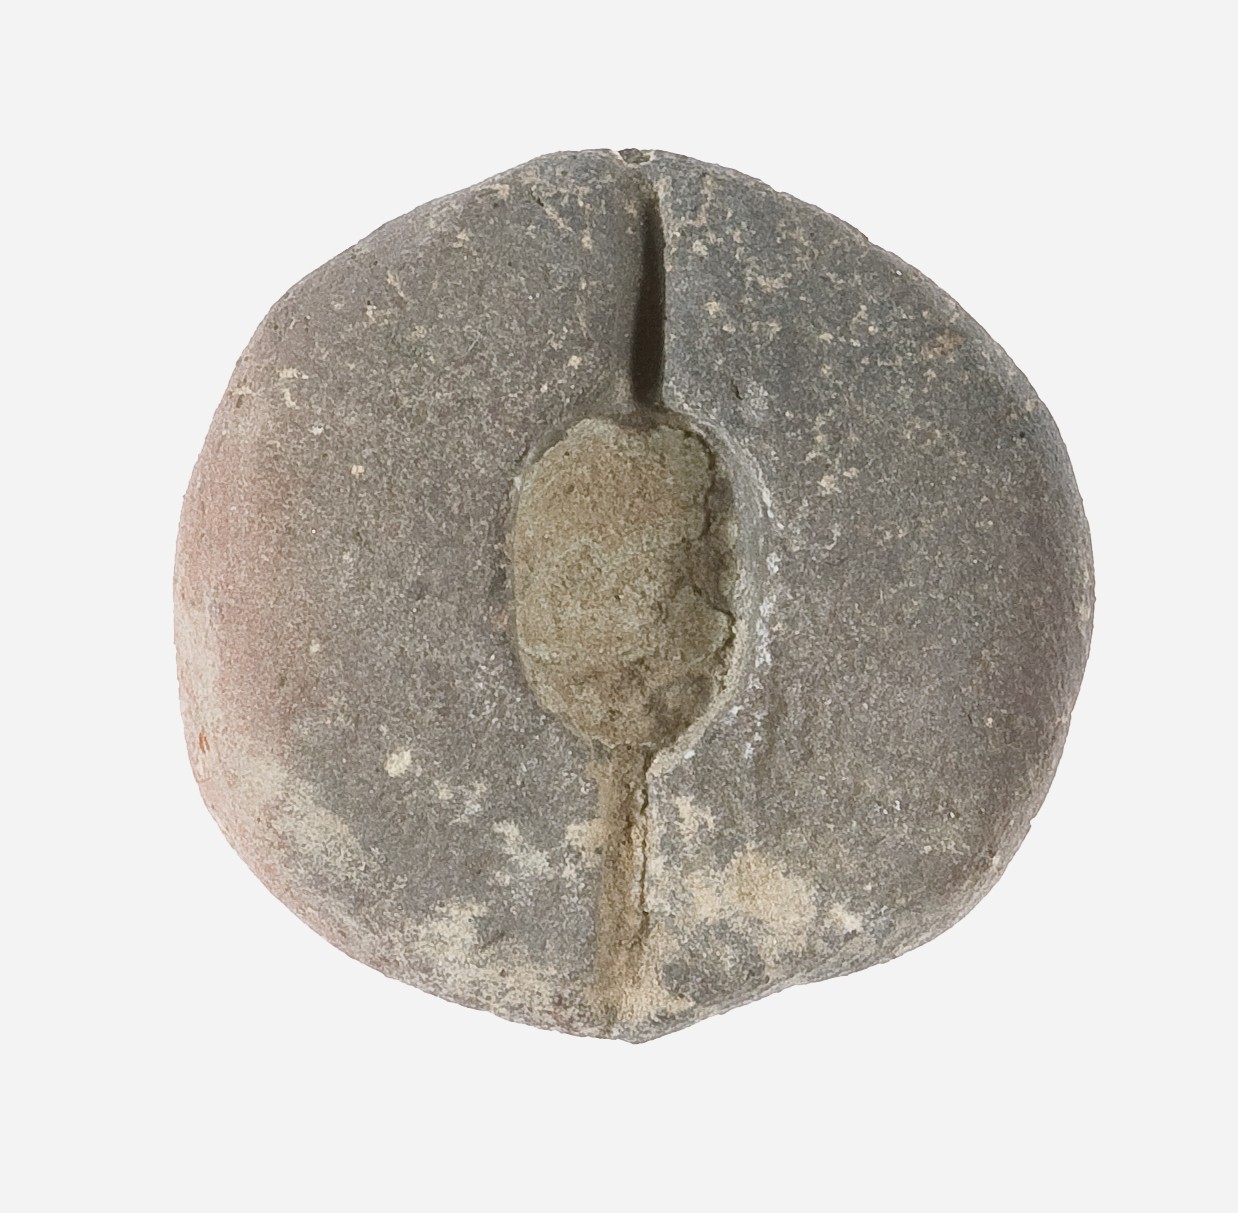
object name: mold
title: Mold for Small Ovoid Beads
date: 1390-1352 BCE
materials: pottery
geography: egypt